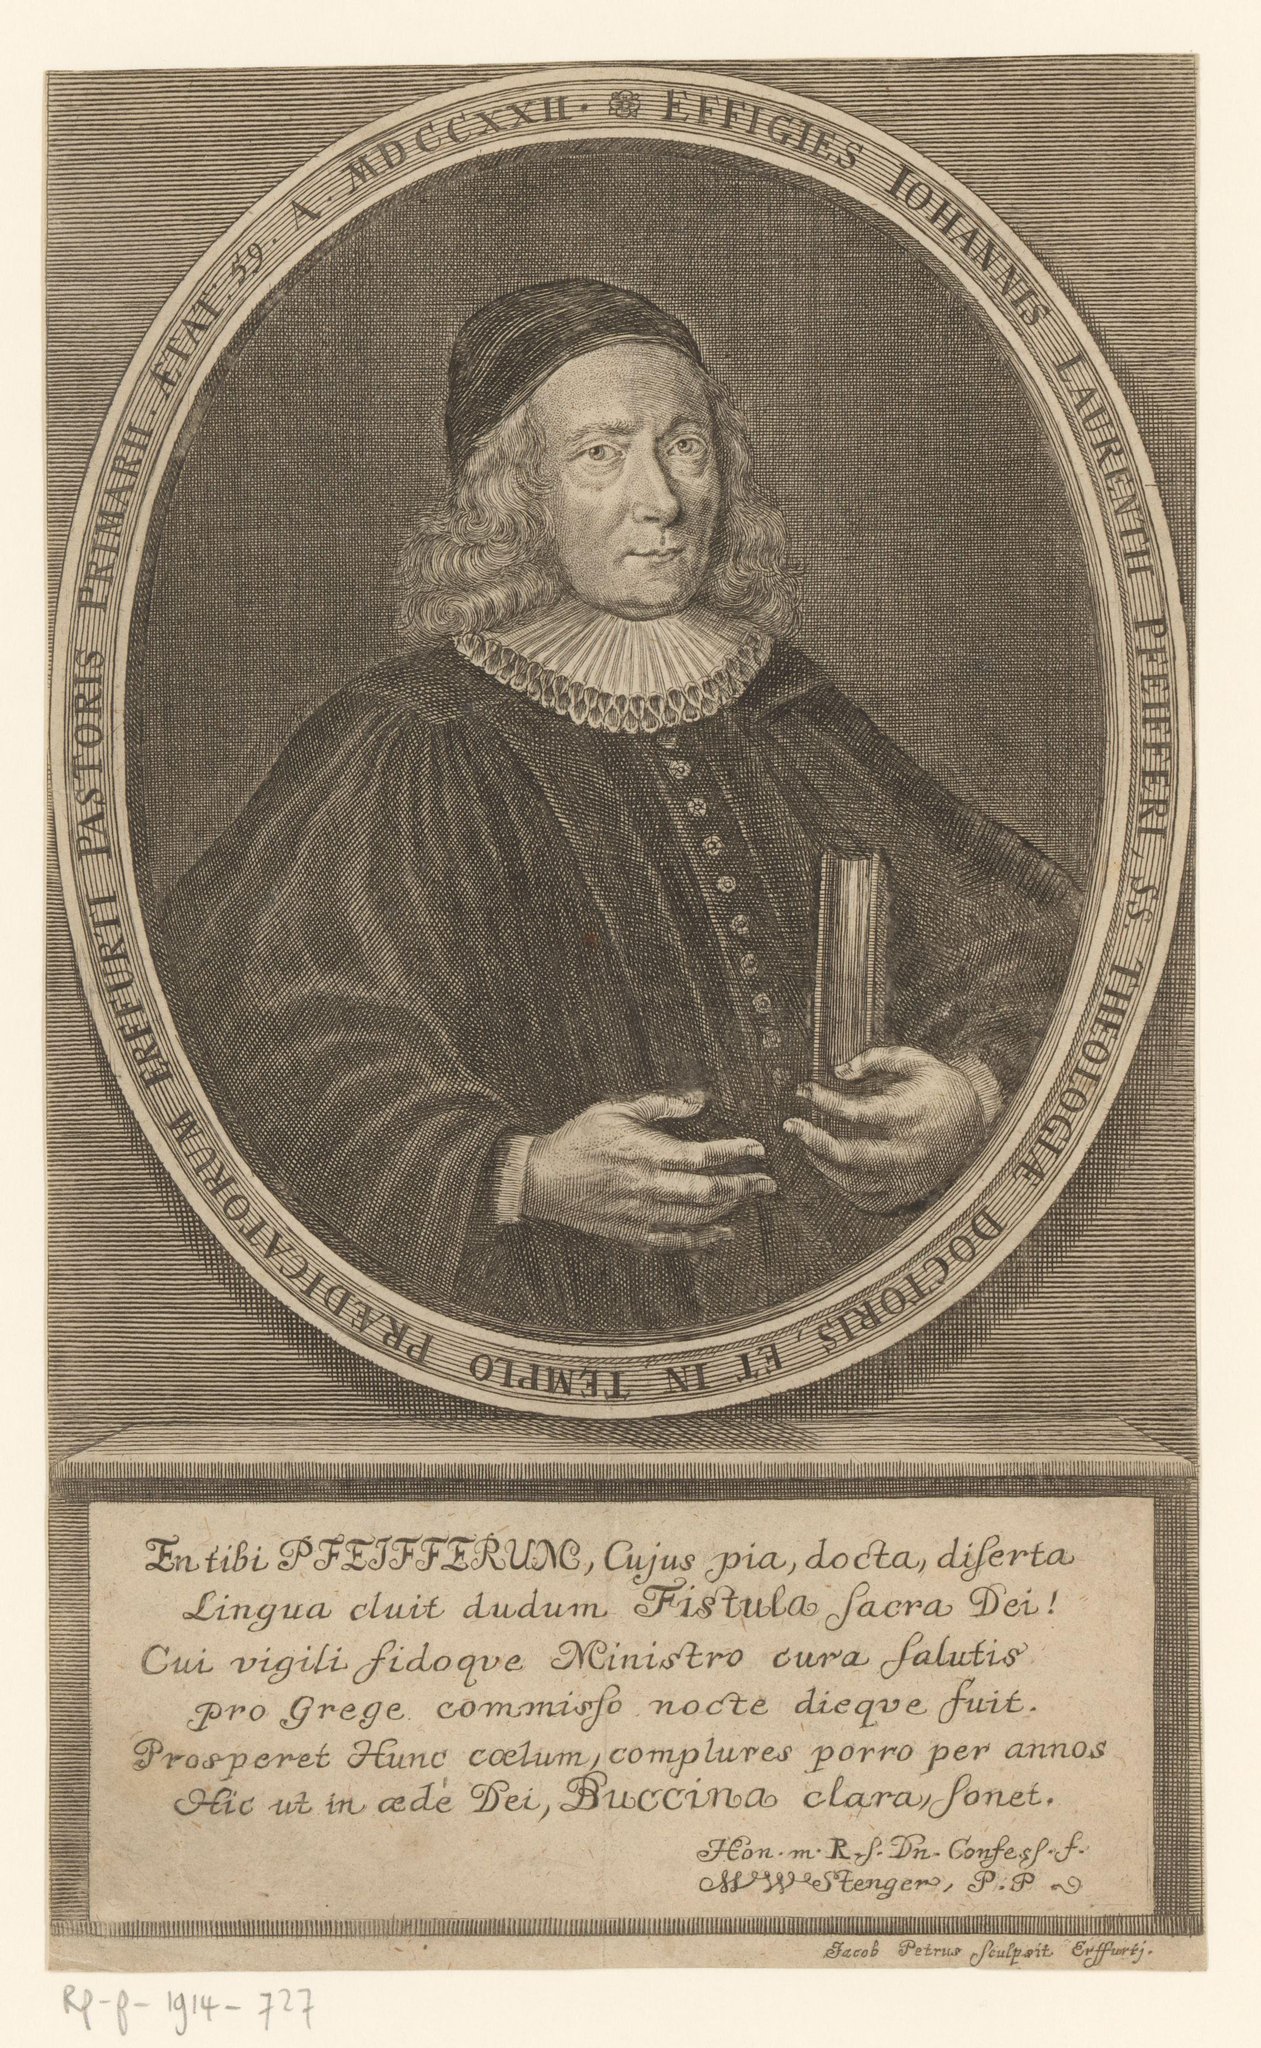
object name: print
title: Portret van Johann Lorenz Pfeiffer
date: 1722-1749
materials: paper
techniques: engraving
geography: erfurt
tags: theologian, historical persons, book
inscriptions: collector's mark: Lugt 2228